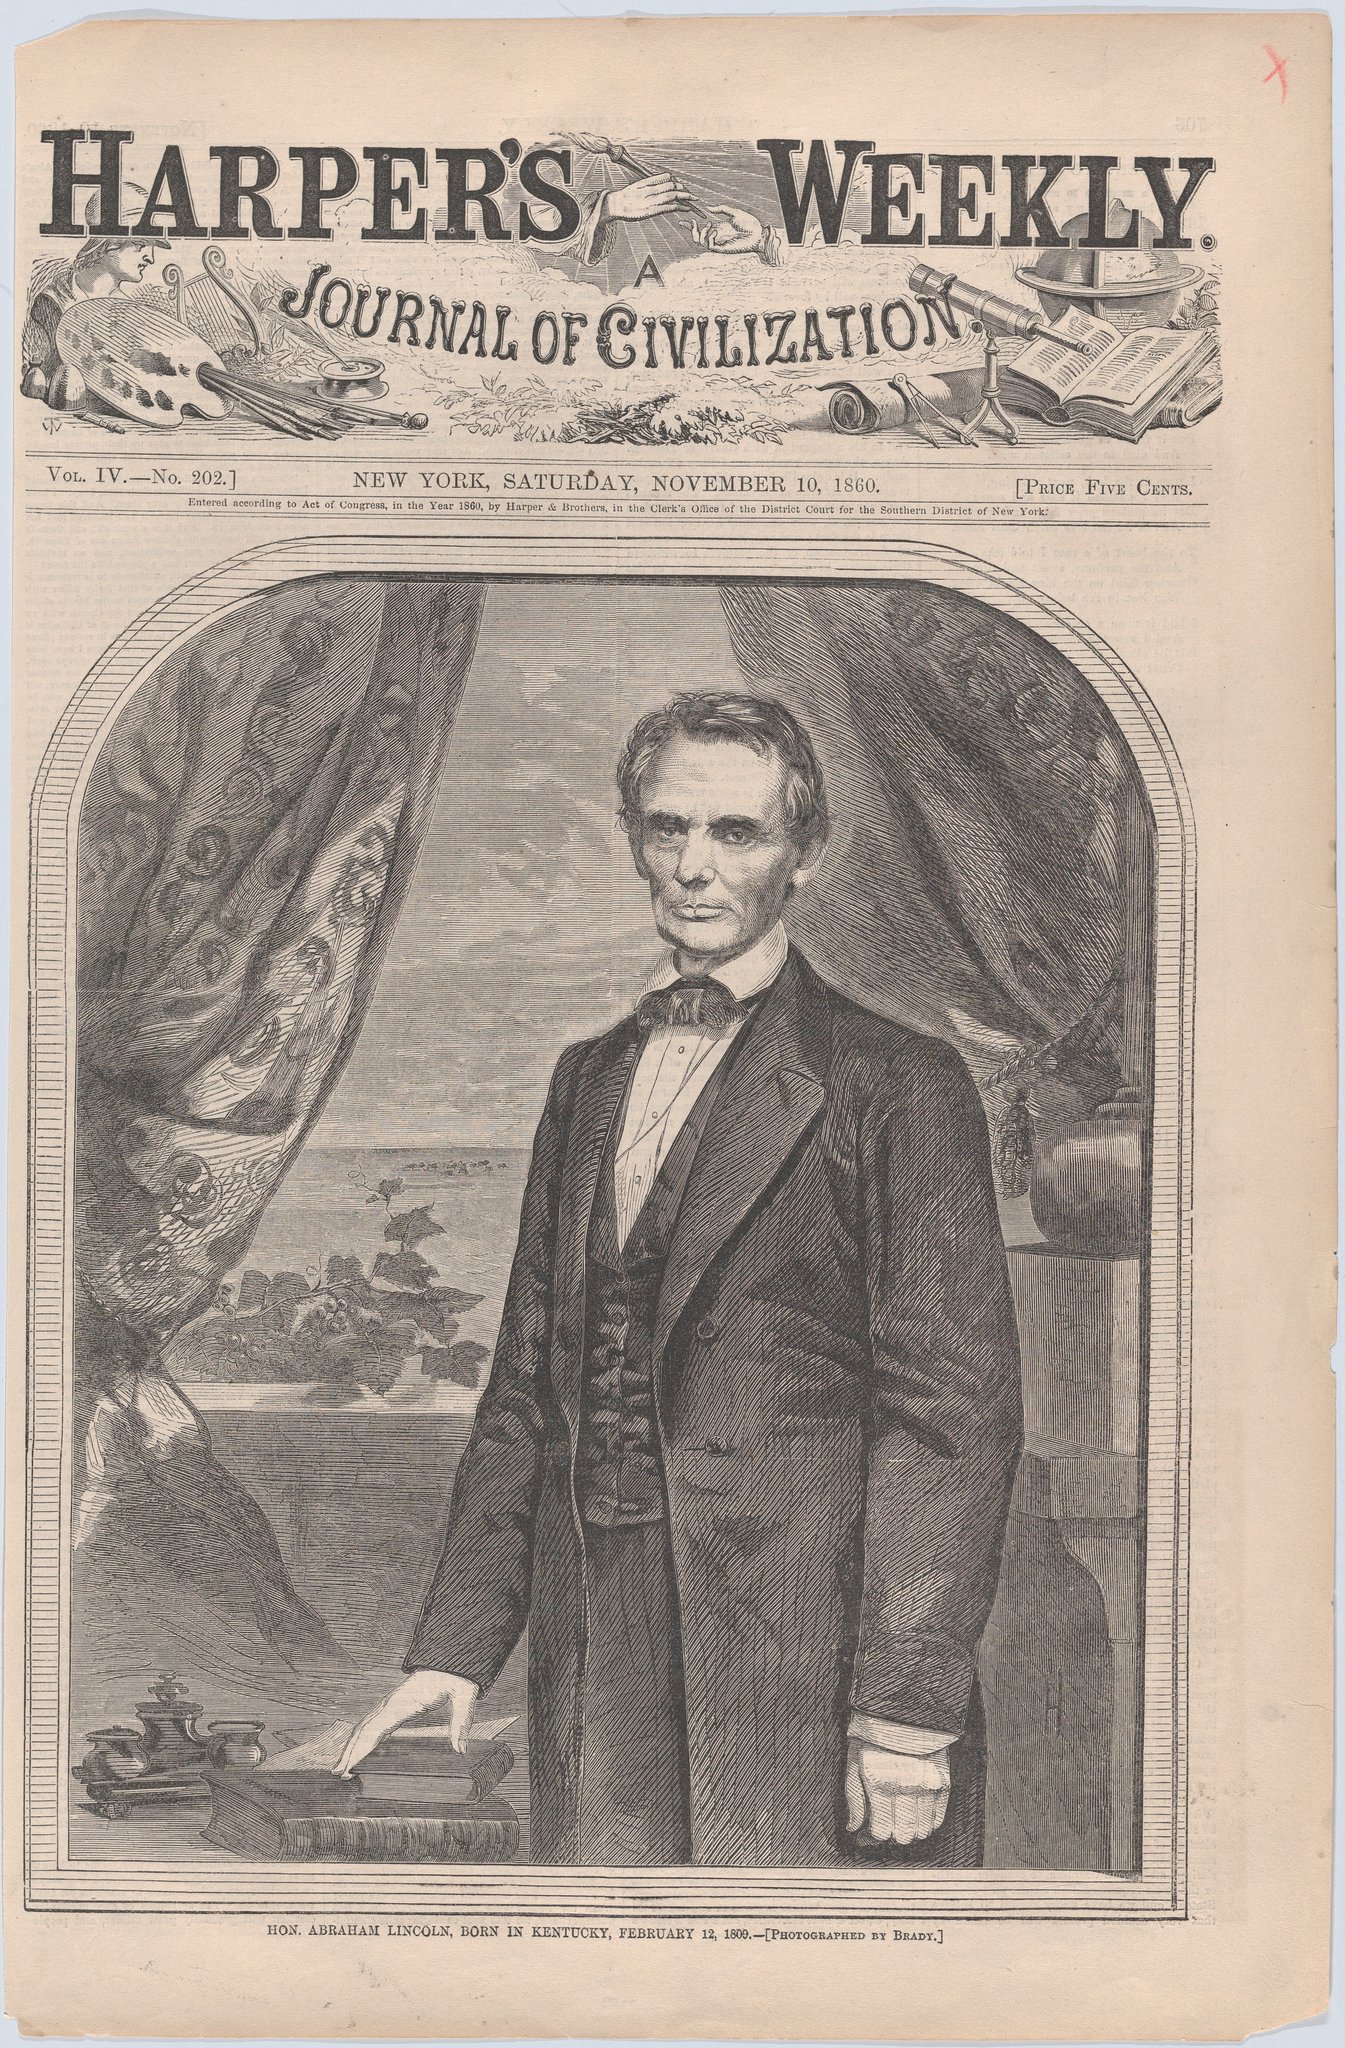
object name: print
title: Hon. Abraham Lincoln, born in Kentucky, February 12, 1809 (from "Harper's Weekly," Vol. IV)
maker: mathew b. brady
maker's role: photographer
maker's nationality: american, born ireland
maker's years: 1823-1896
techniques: photography, engraving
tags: abraham lincoln